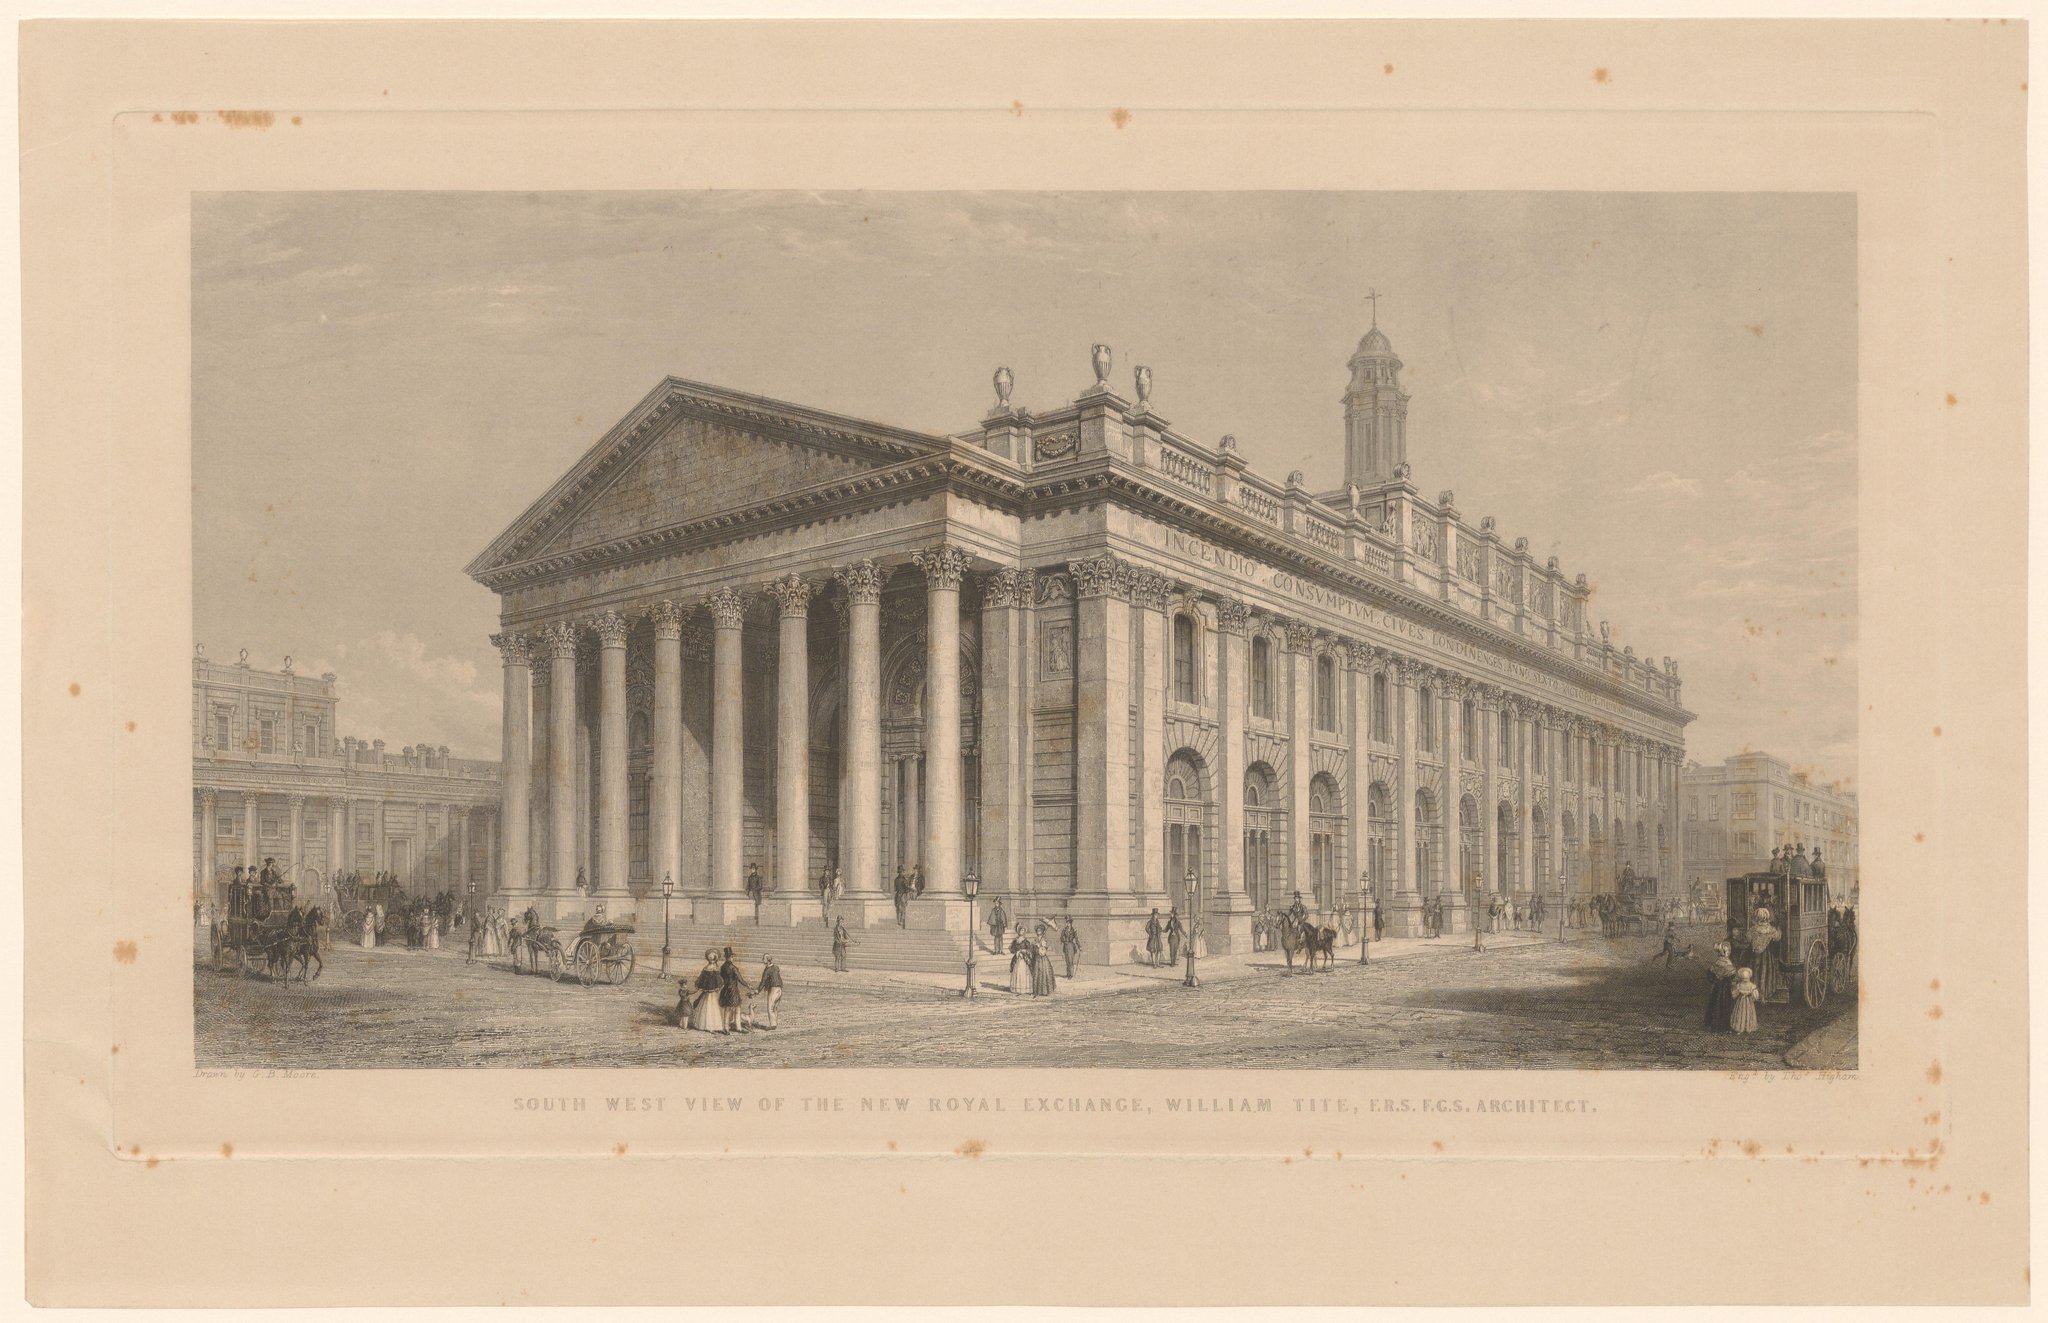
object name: print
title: South West View of the New Royal Exchange, William Tite, F.R.S. F.G.S. Architect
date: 1839-1841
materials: paper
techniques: engraving, etching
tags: exchange, bourse, city-view in general; 'veduta' (+ city(-scape) with figures, staffage)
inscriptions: collector's mark: Lugt 12